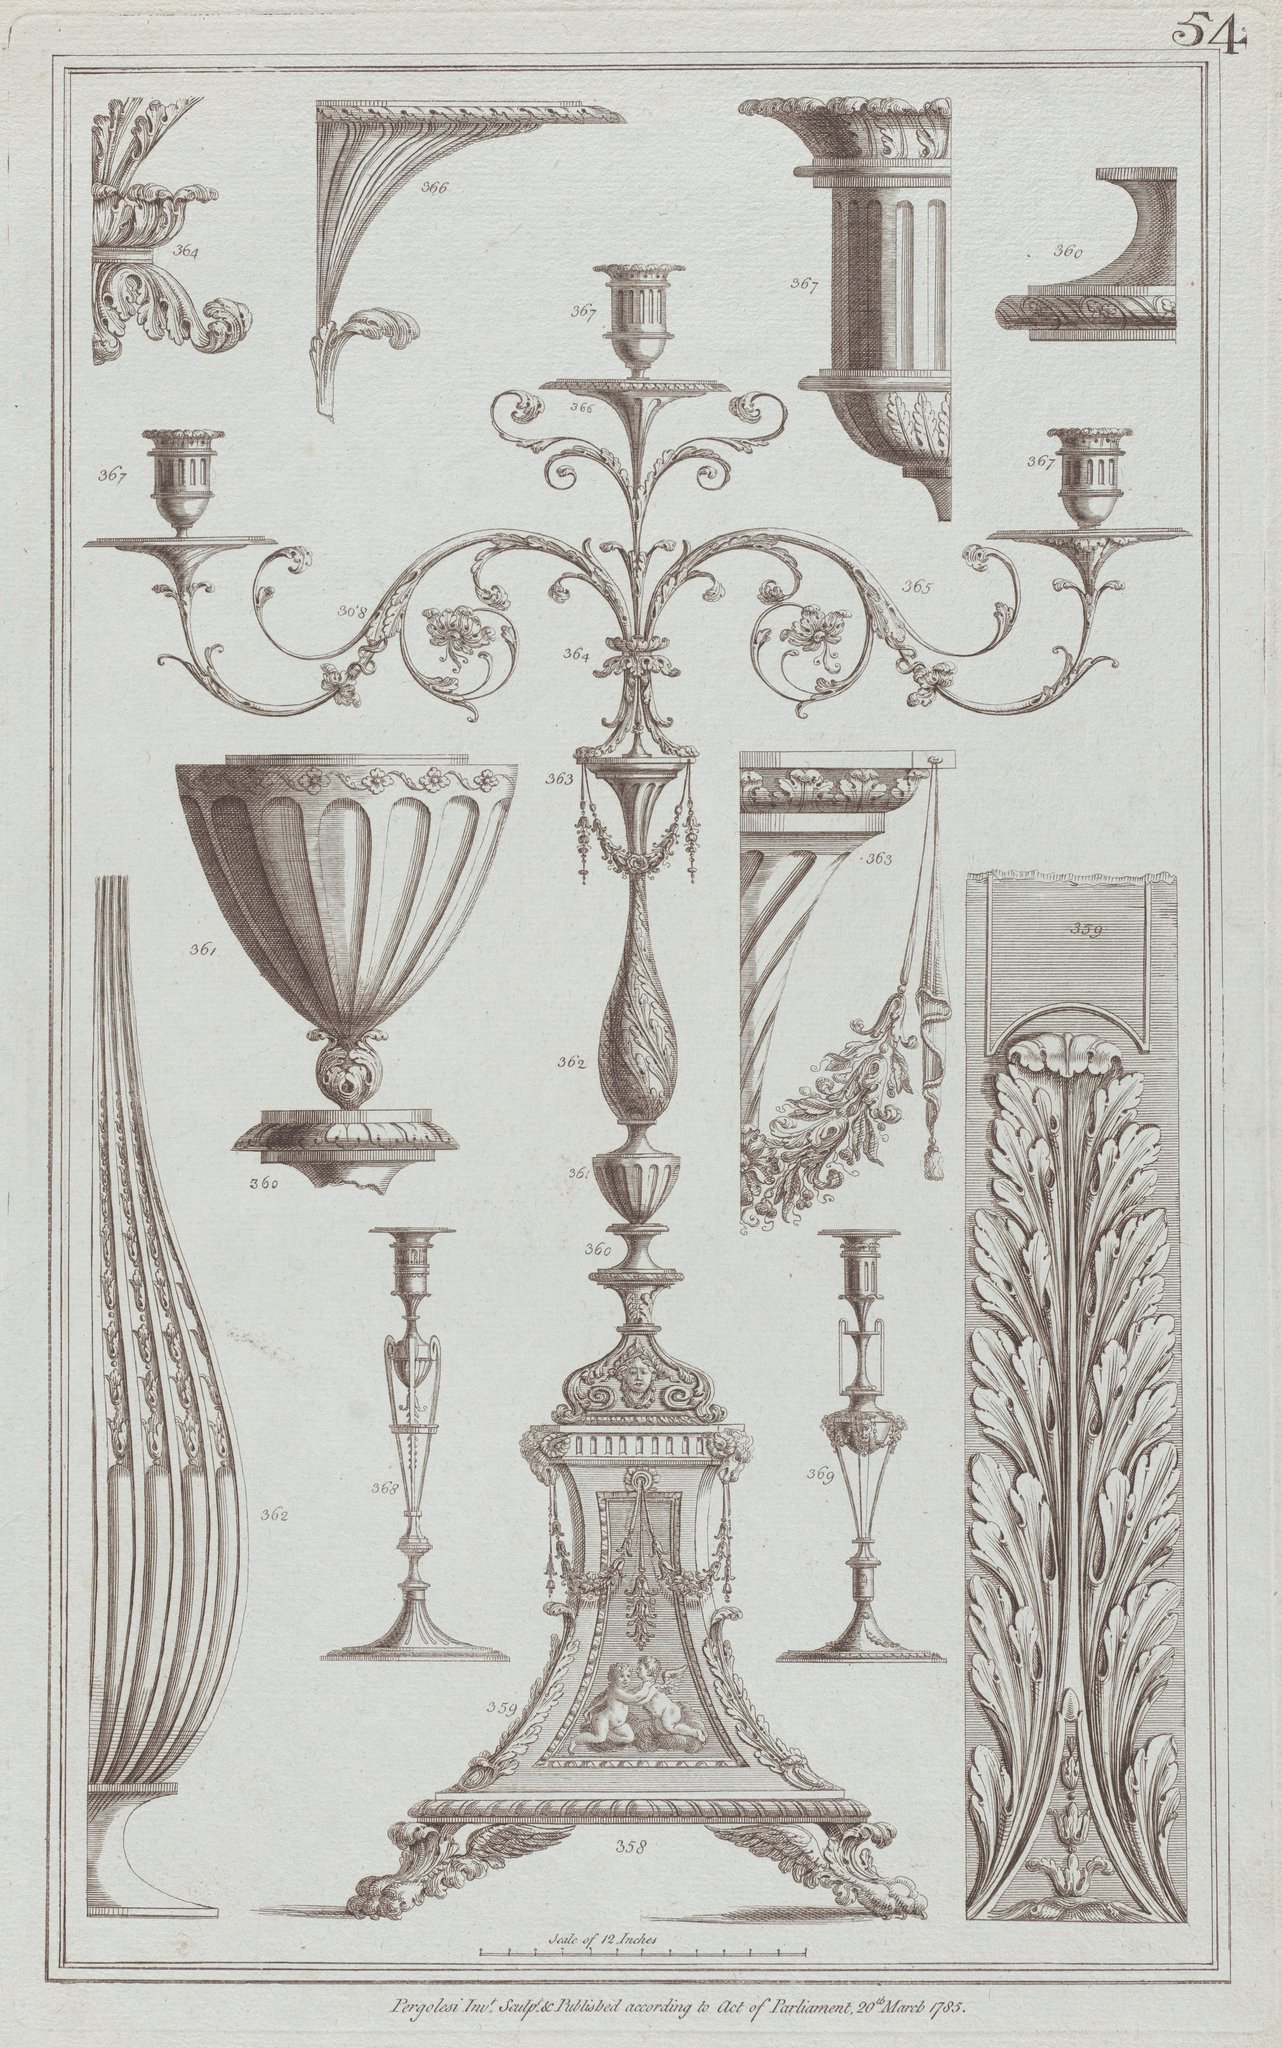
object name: print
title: Candelabra, Vessels and Ornament, nos. 358–369, plate 54 from "Designs for Various Ornaments"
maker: michelangelo pergolesi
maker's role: artist and publisher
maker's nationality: italian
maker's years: 1760-1801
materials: ink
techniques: engraving, etching, printing